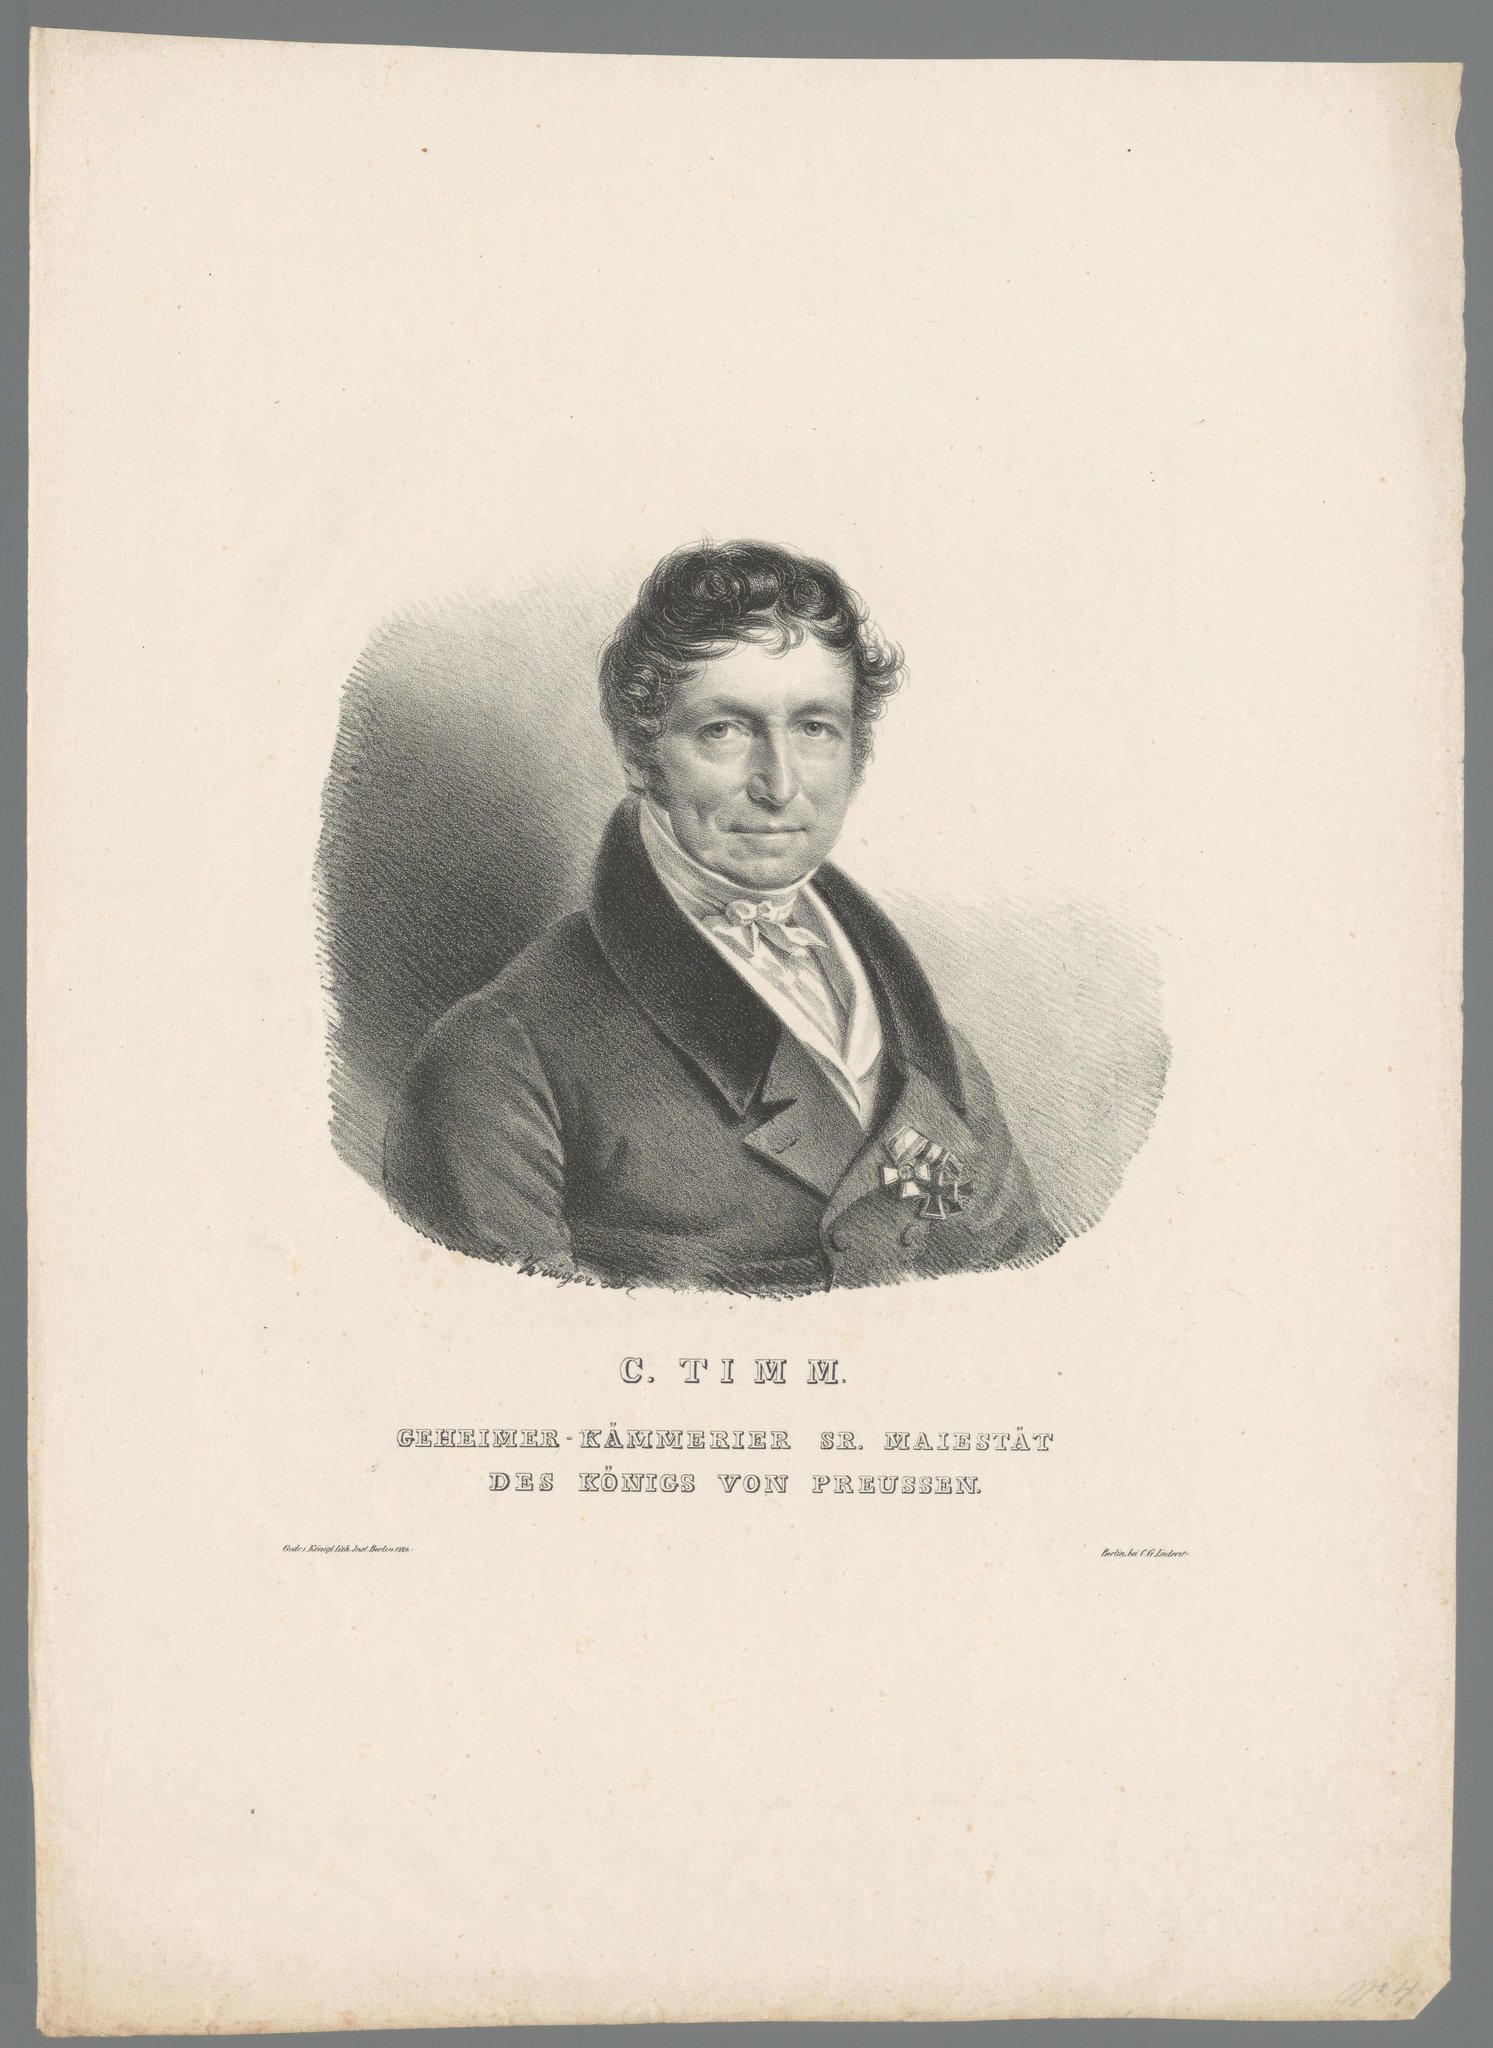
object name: print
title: Portret van C. Timm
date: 1826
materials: paper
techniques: lithograph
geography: berlin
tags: historical persons not known by name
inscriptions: collector's mark: Lugt 2233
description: Portret van een verder onbekende man met de naam C. Timm.